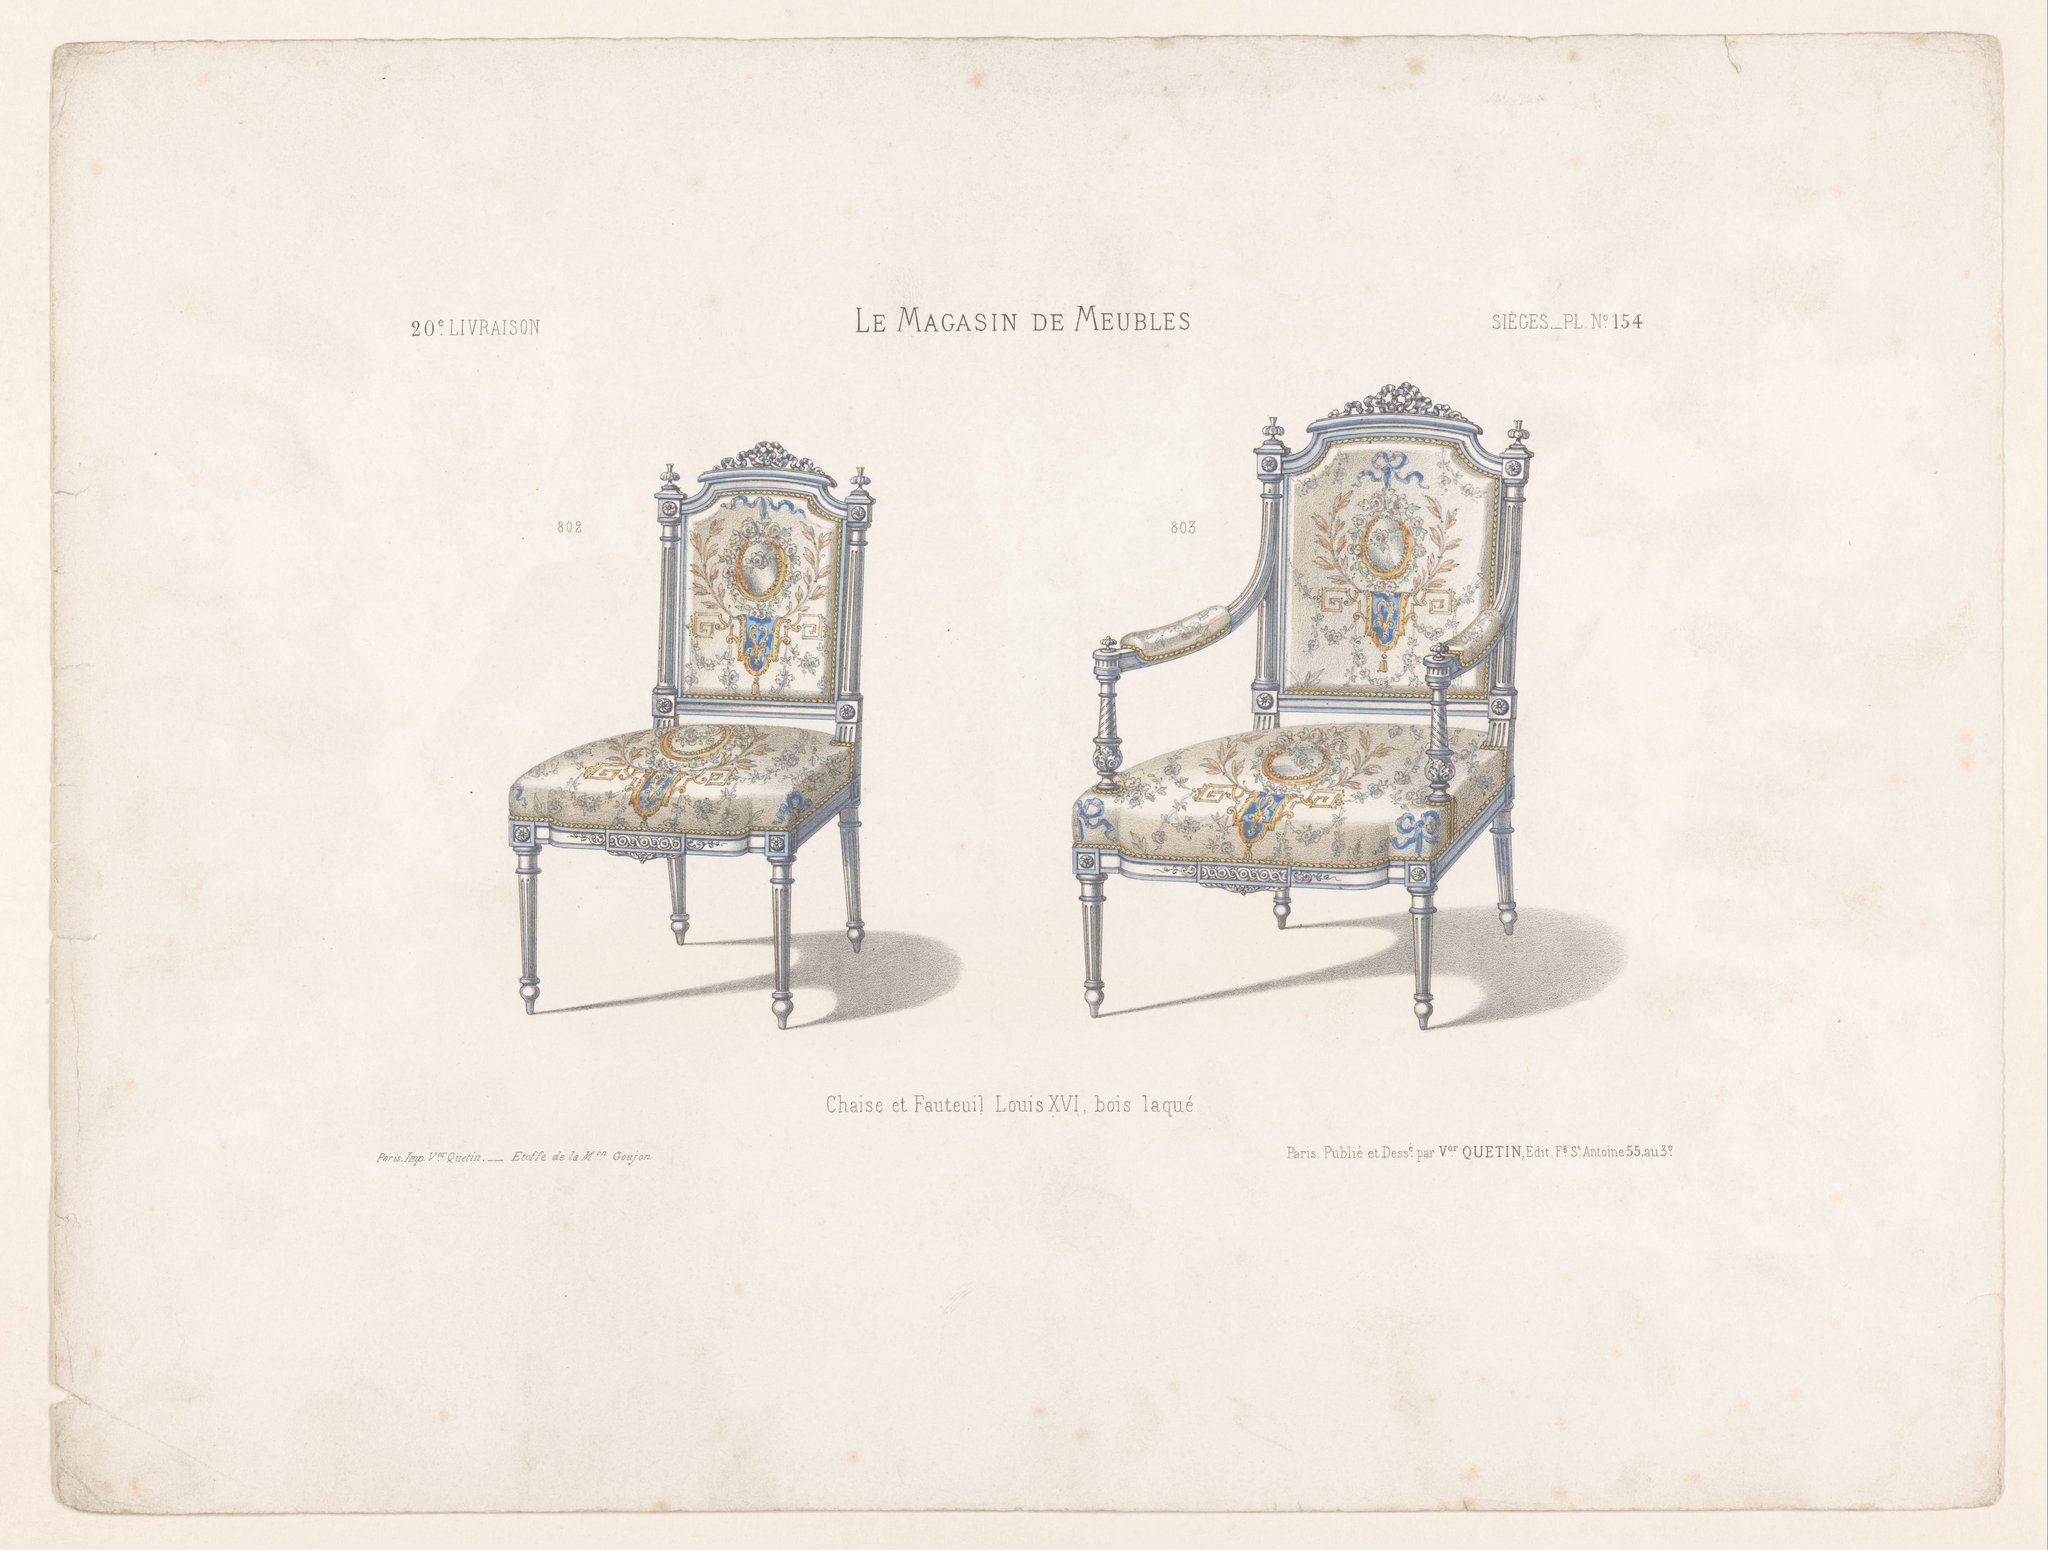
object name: print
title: Chaise et Fauteuil Louis XVI, bois laqué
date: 1832-1877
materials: paper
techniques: hand coloring, lithograph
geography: paris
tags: seating furniture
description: Een stoel en fauteuil in de Lodewijk XVI-stijl. Prent uit 20e Livraison.